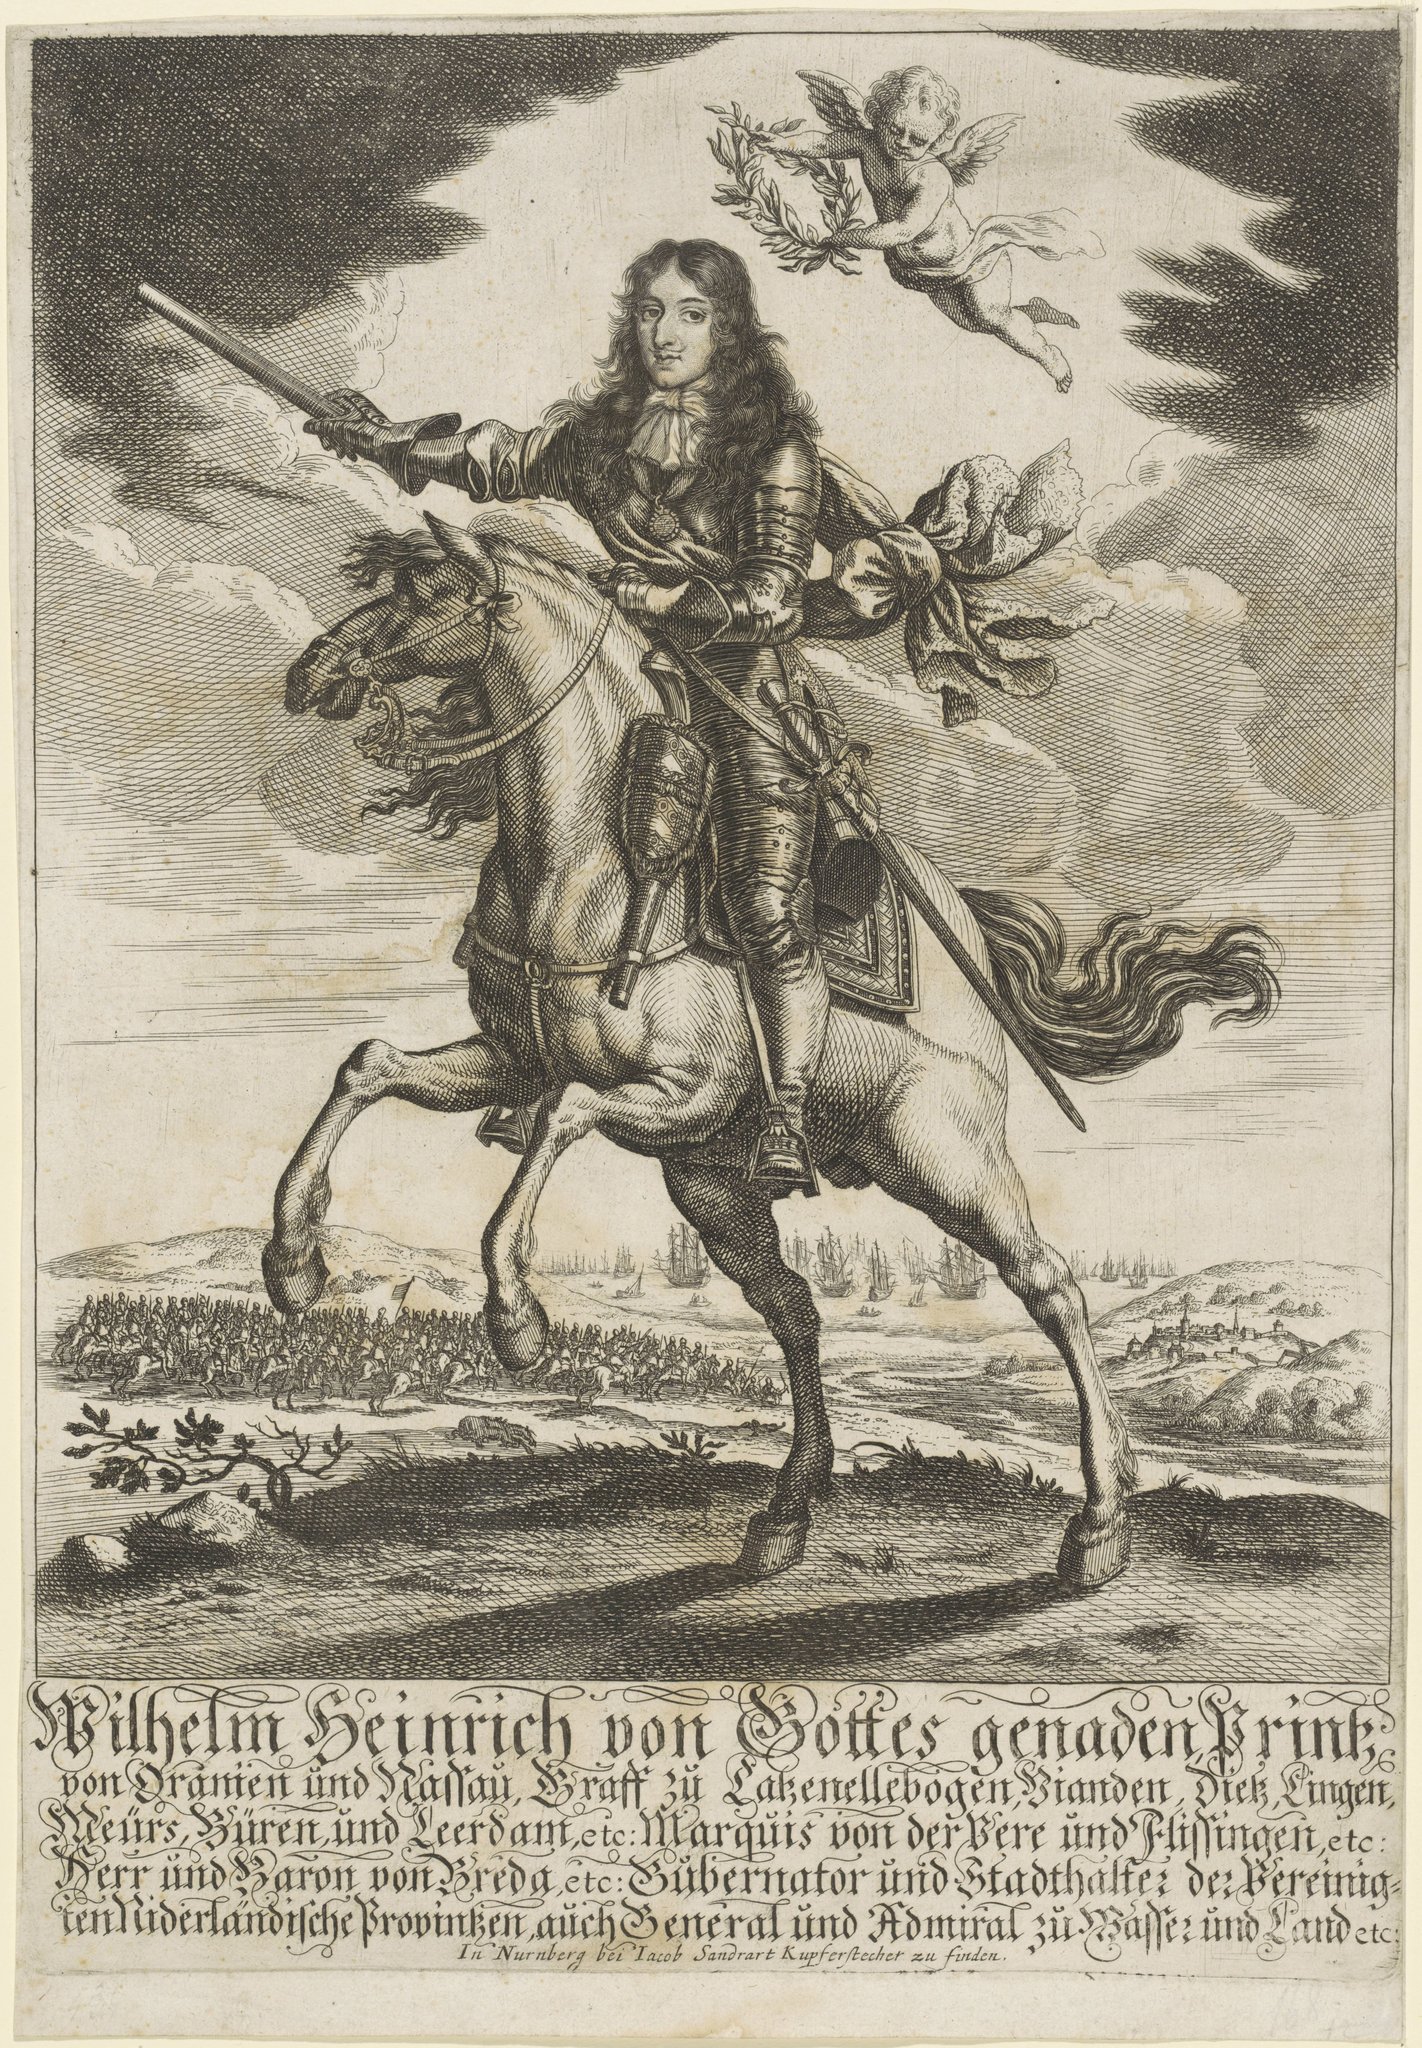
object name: print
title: Ruiterportret van Willem III, prins van Oranje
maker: jakob von sandrart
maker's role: print maker, publisher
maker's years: 1630-1708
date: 1688-1708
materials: paper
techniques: engraving, etching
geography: nuremberg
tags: the hague, william iii (prince of orange and king of england, scotland, and ireland)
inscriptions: collector's mark: Lugt 2228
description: Ruiterportret van Willem III. In zijn rechterhand een commandostaf. Een putto houdt een lauwerkrans boven zijn hoofd. Op de achtergrond een strand met ruiters en schepen. In de ondermarge vijf regels Duitse tekst.